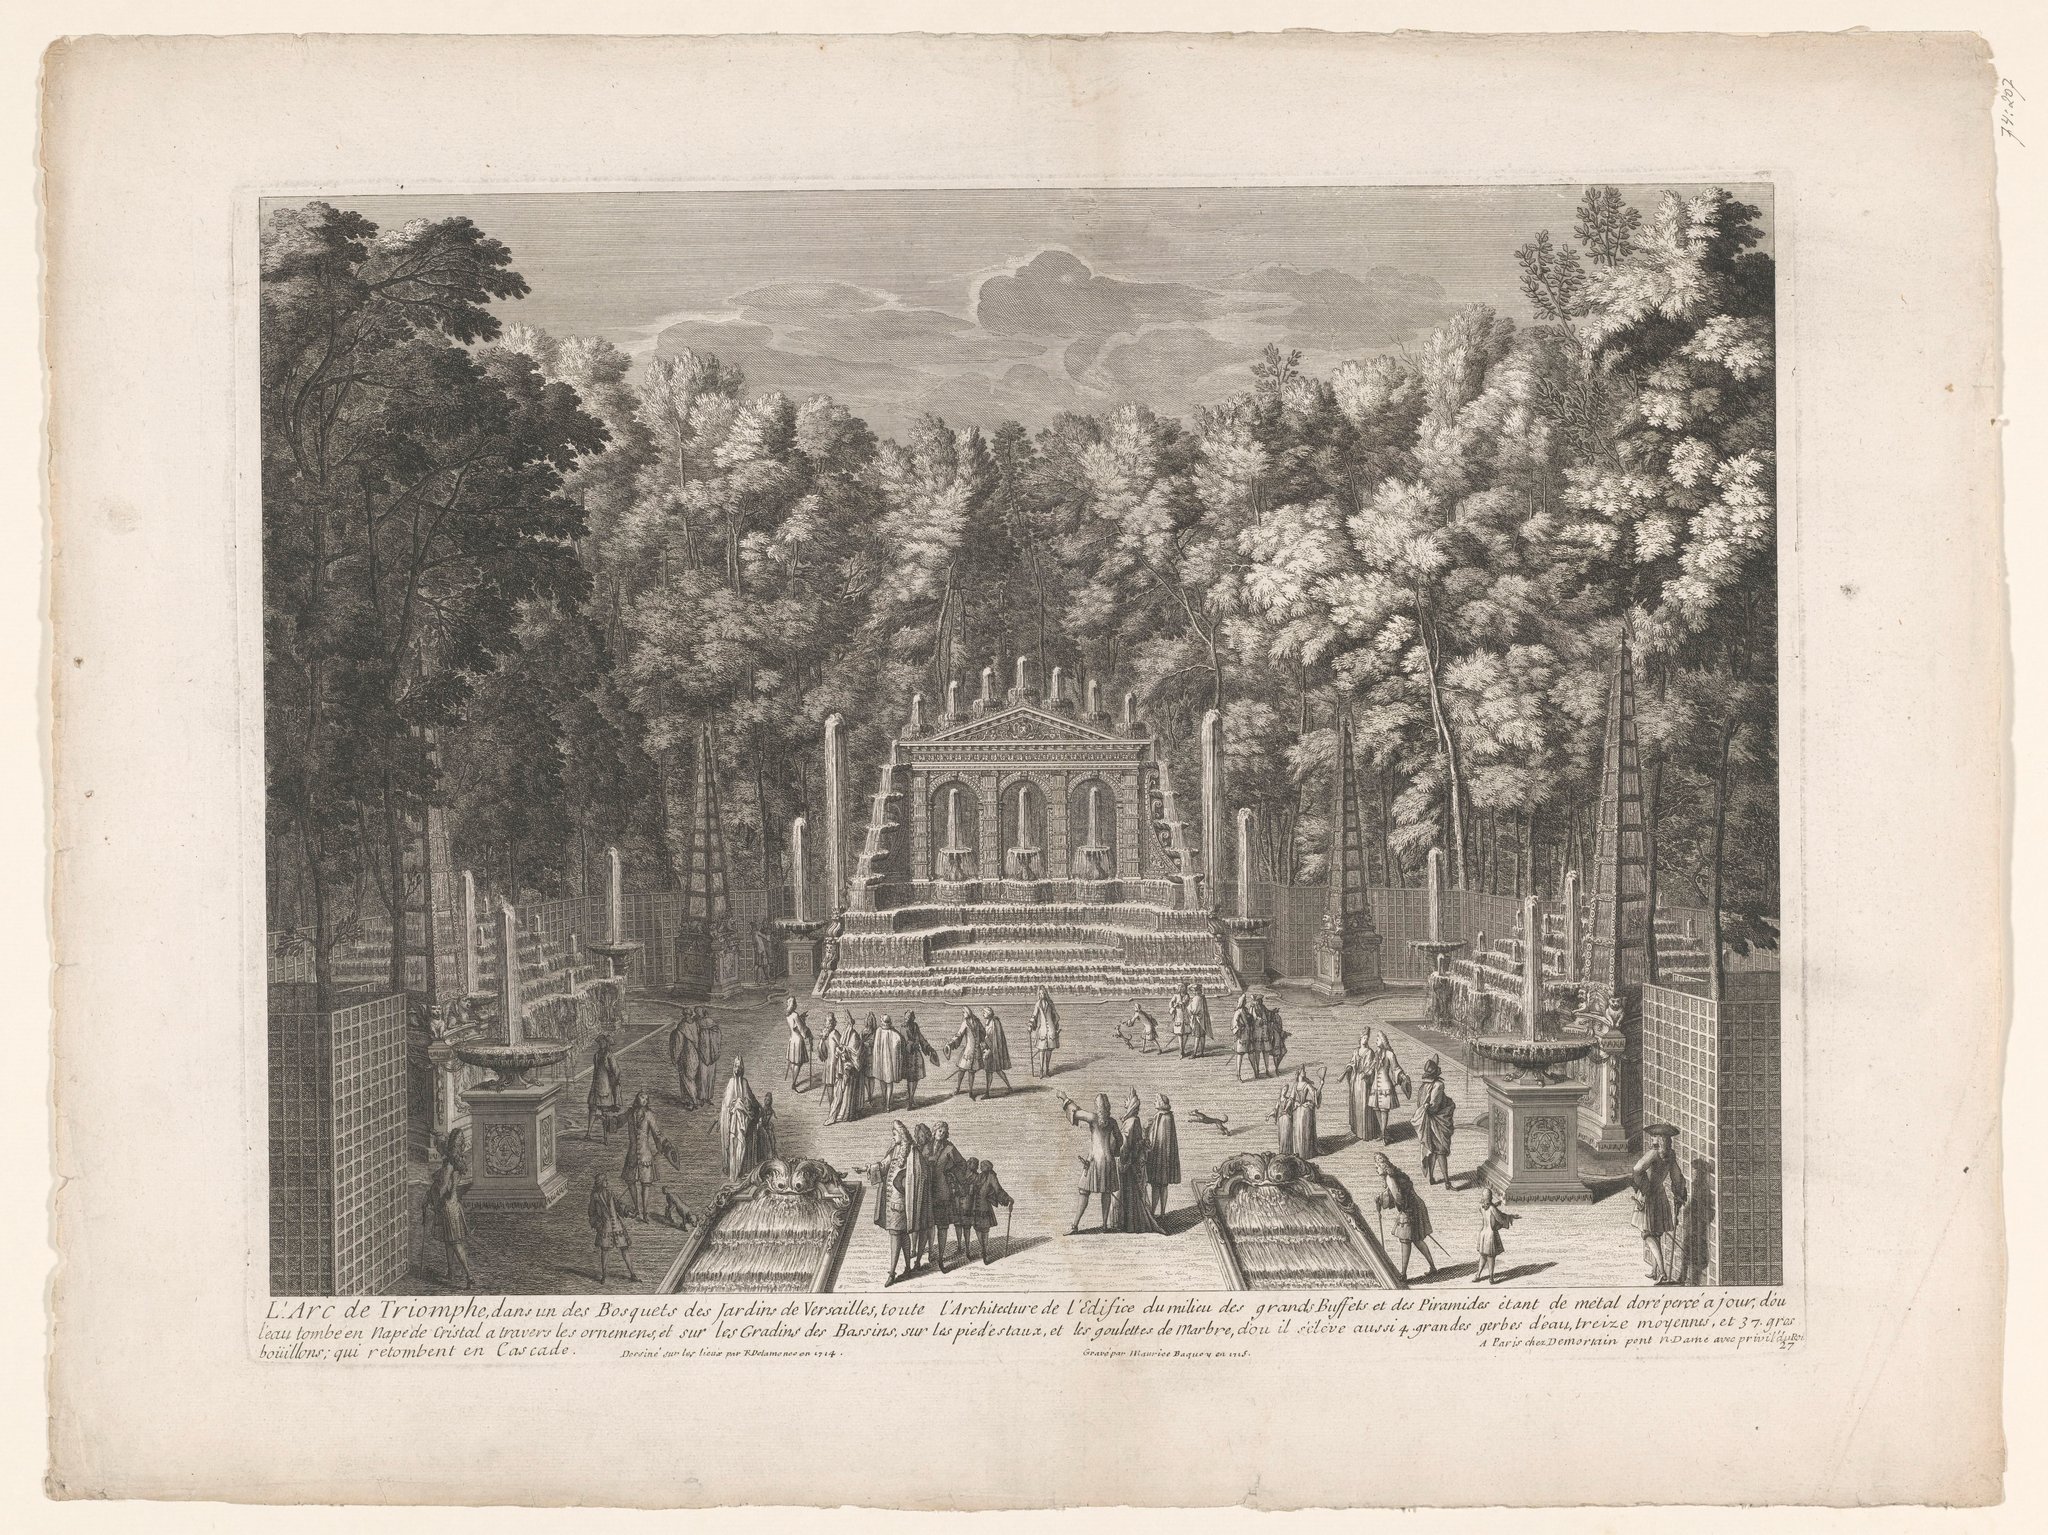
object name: print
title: De triomfboog in de tuin van Versailles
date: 1715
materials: paper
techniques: engraving, etching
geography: paris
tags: garden fountain, french or architectonic garden; formal garden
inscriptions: collector's mark: Lugt 2228, collector's mark: Lugt 2760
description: Prent ook gebruikt in: Les Plans, Profils, Et Elevations, Des Ville, Et Château De Versailles (...). Parijs: Gilles de Demortain, [1715].